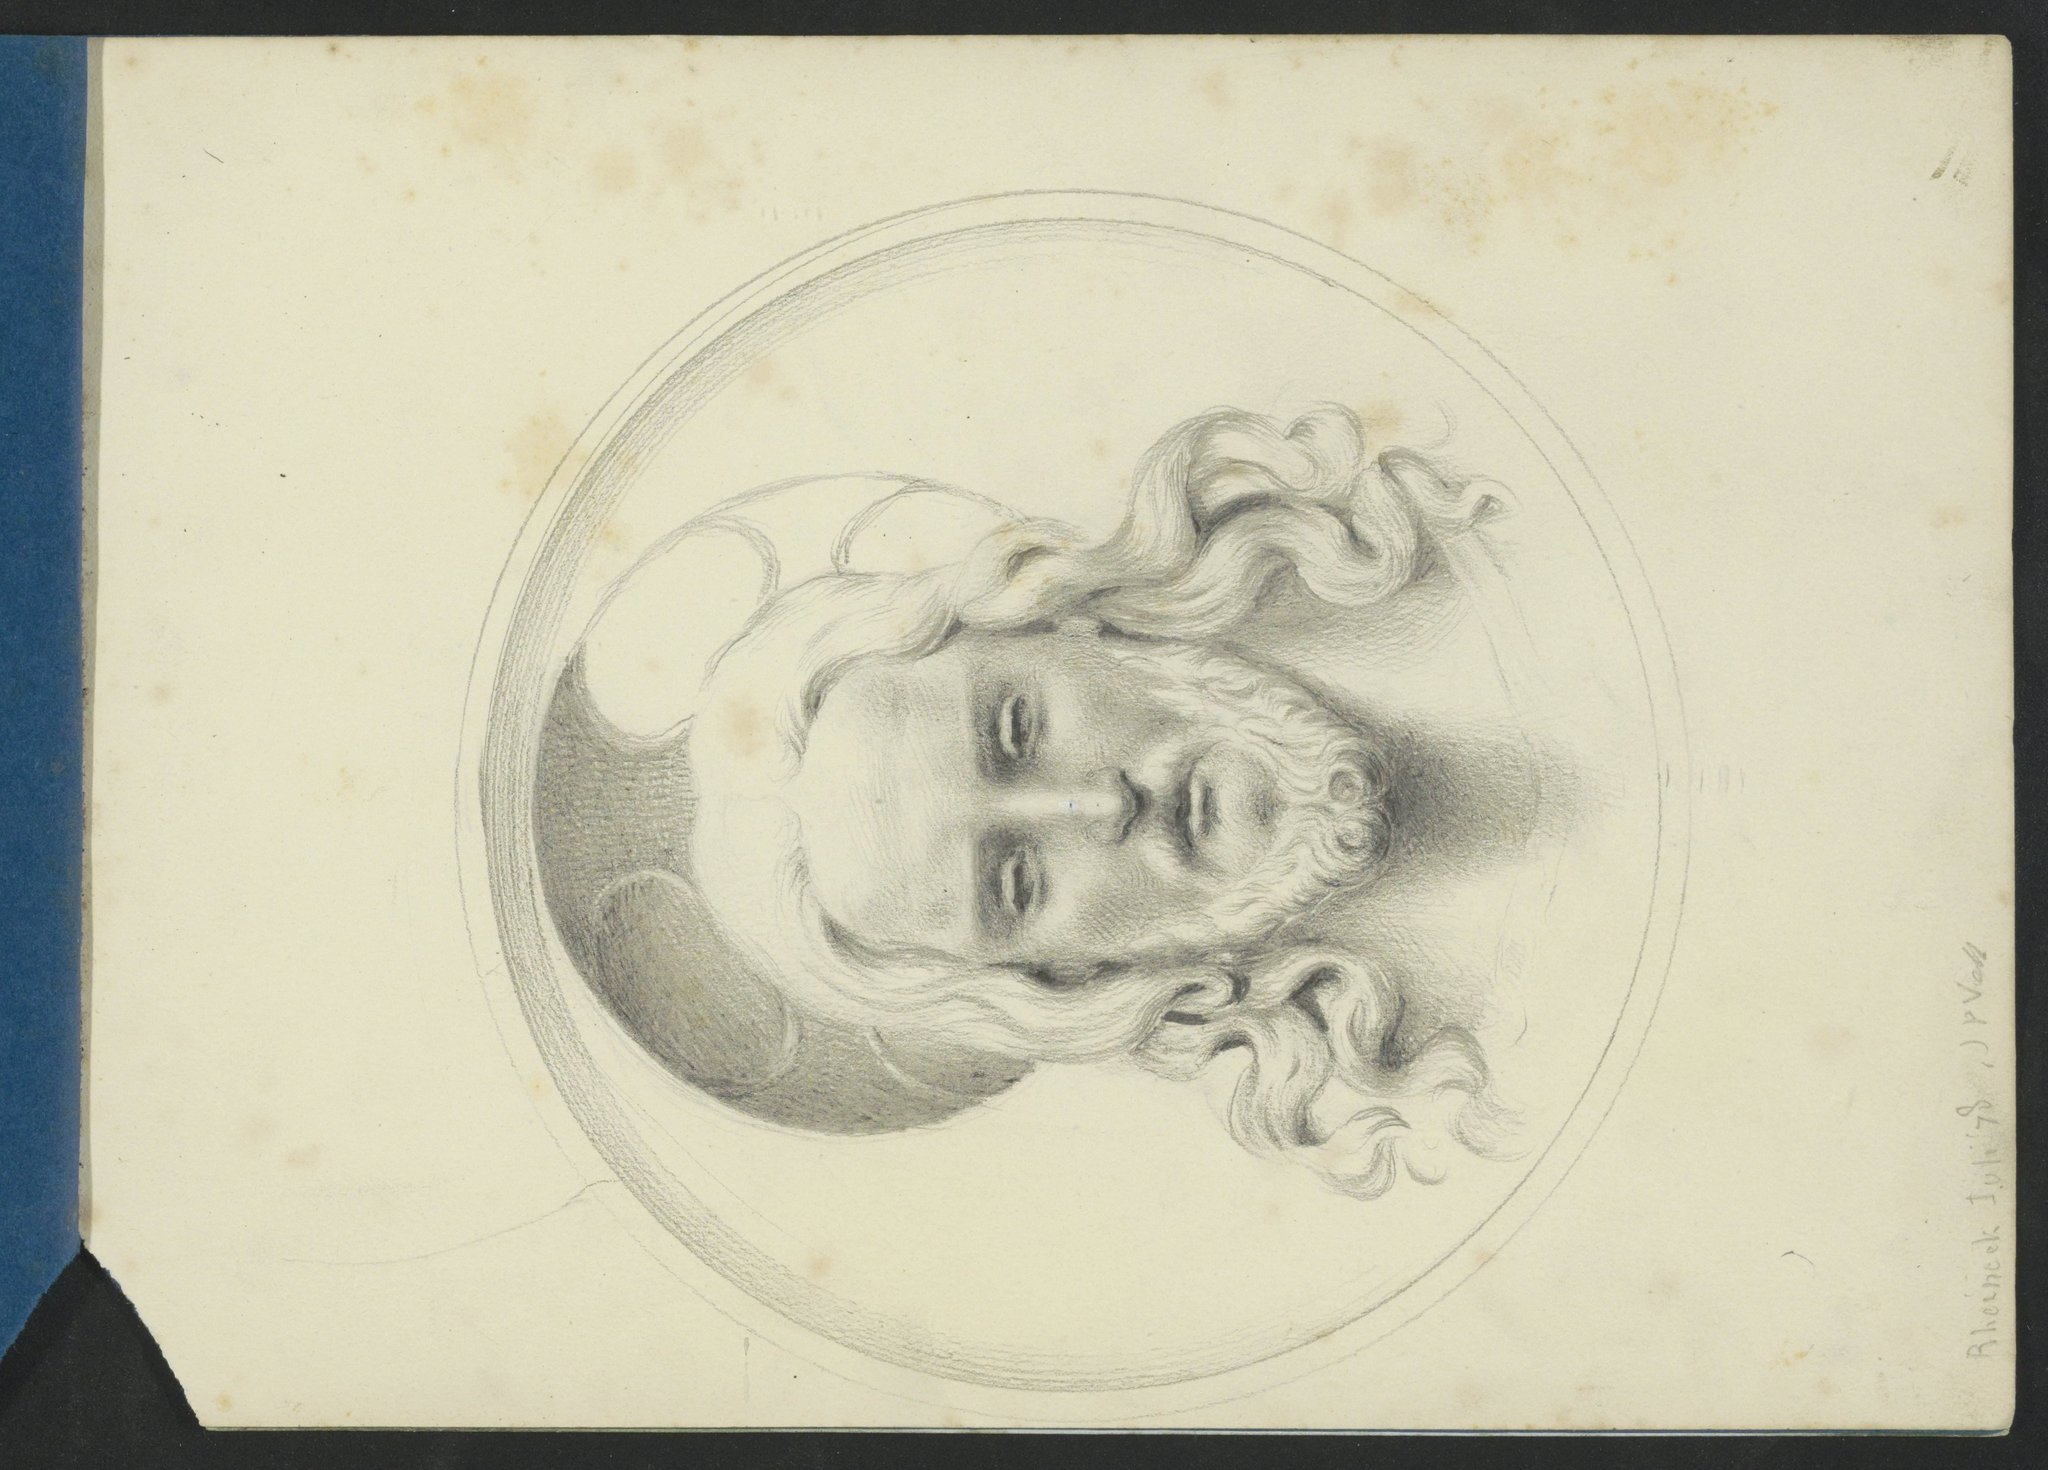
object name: sketchbook leaf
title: Kop van Christus met een nimbus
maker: jan veth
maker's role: designer, draughtsman, painter, print maker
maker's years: 1864-1925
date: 1807-1878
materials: paper, pencil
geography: rheineck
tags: nimbus, halo ~ radiance emanating from persons or things, head (human), adult man, christ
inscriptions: signature and date: ‘Rheineck Juli '78 JP Veth’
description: Blad 3 recto uit een schetsboek met 4 bladen.